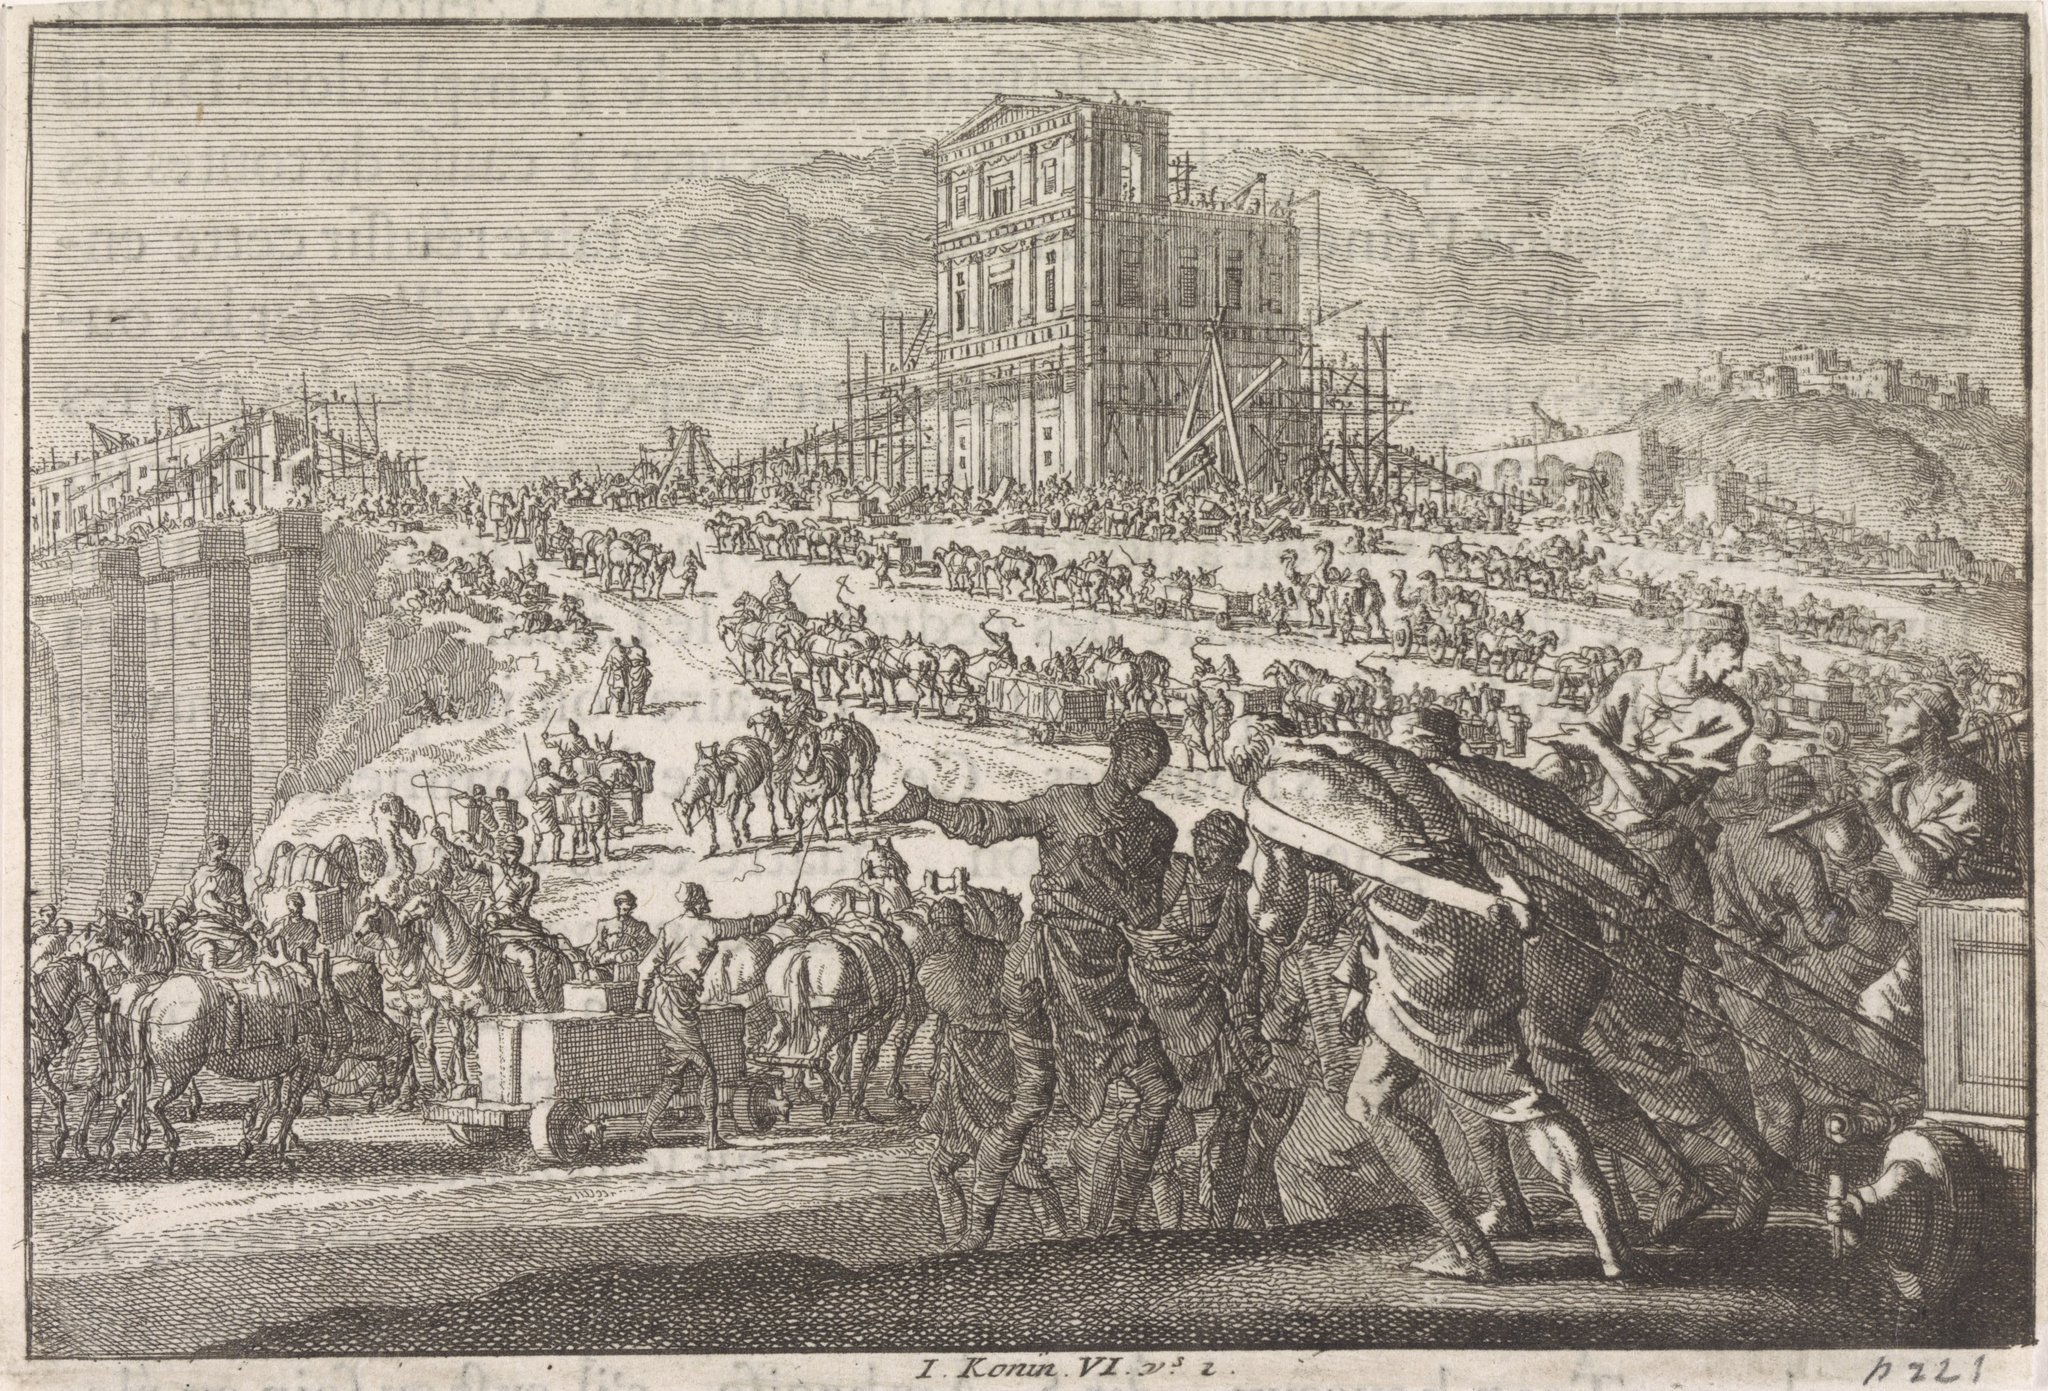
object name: book illustration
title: Koning Salomo bouwt de tempel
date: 1703-1762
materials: paper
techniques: etching, letterpress printing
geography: haarlem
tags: the building of the temple of solomon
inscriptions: collector's mark: Lugt 2228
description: De prent komt een eerste keer voor als boekillustratie voor David Martin. Historie des Ouden en Nieuwen Testaments. Amsterdam, Pieter Mortier, 1703. Deel I. De boekillustraties voor de Mortierbijbel hebben verschillende staten en kopieën, waarbij de chronologische volgorde moeilijk te achterhalen valt. Als boekillustraties werden ze bovendien herhaaldelijk opnieuw gebruikt voor andere boekwerken.